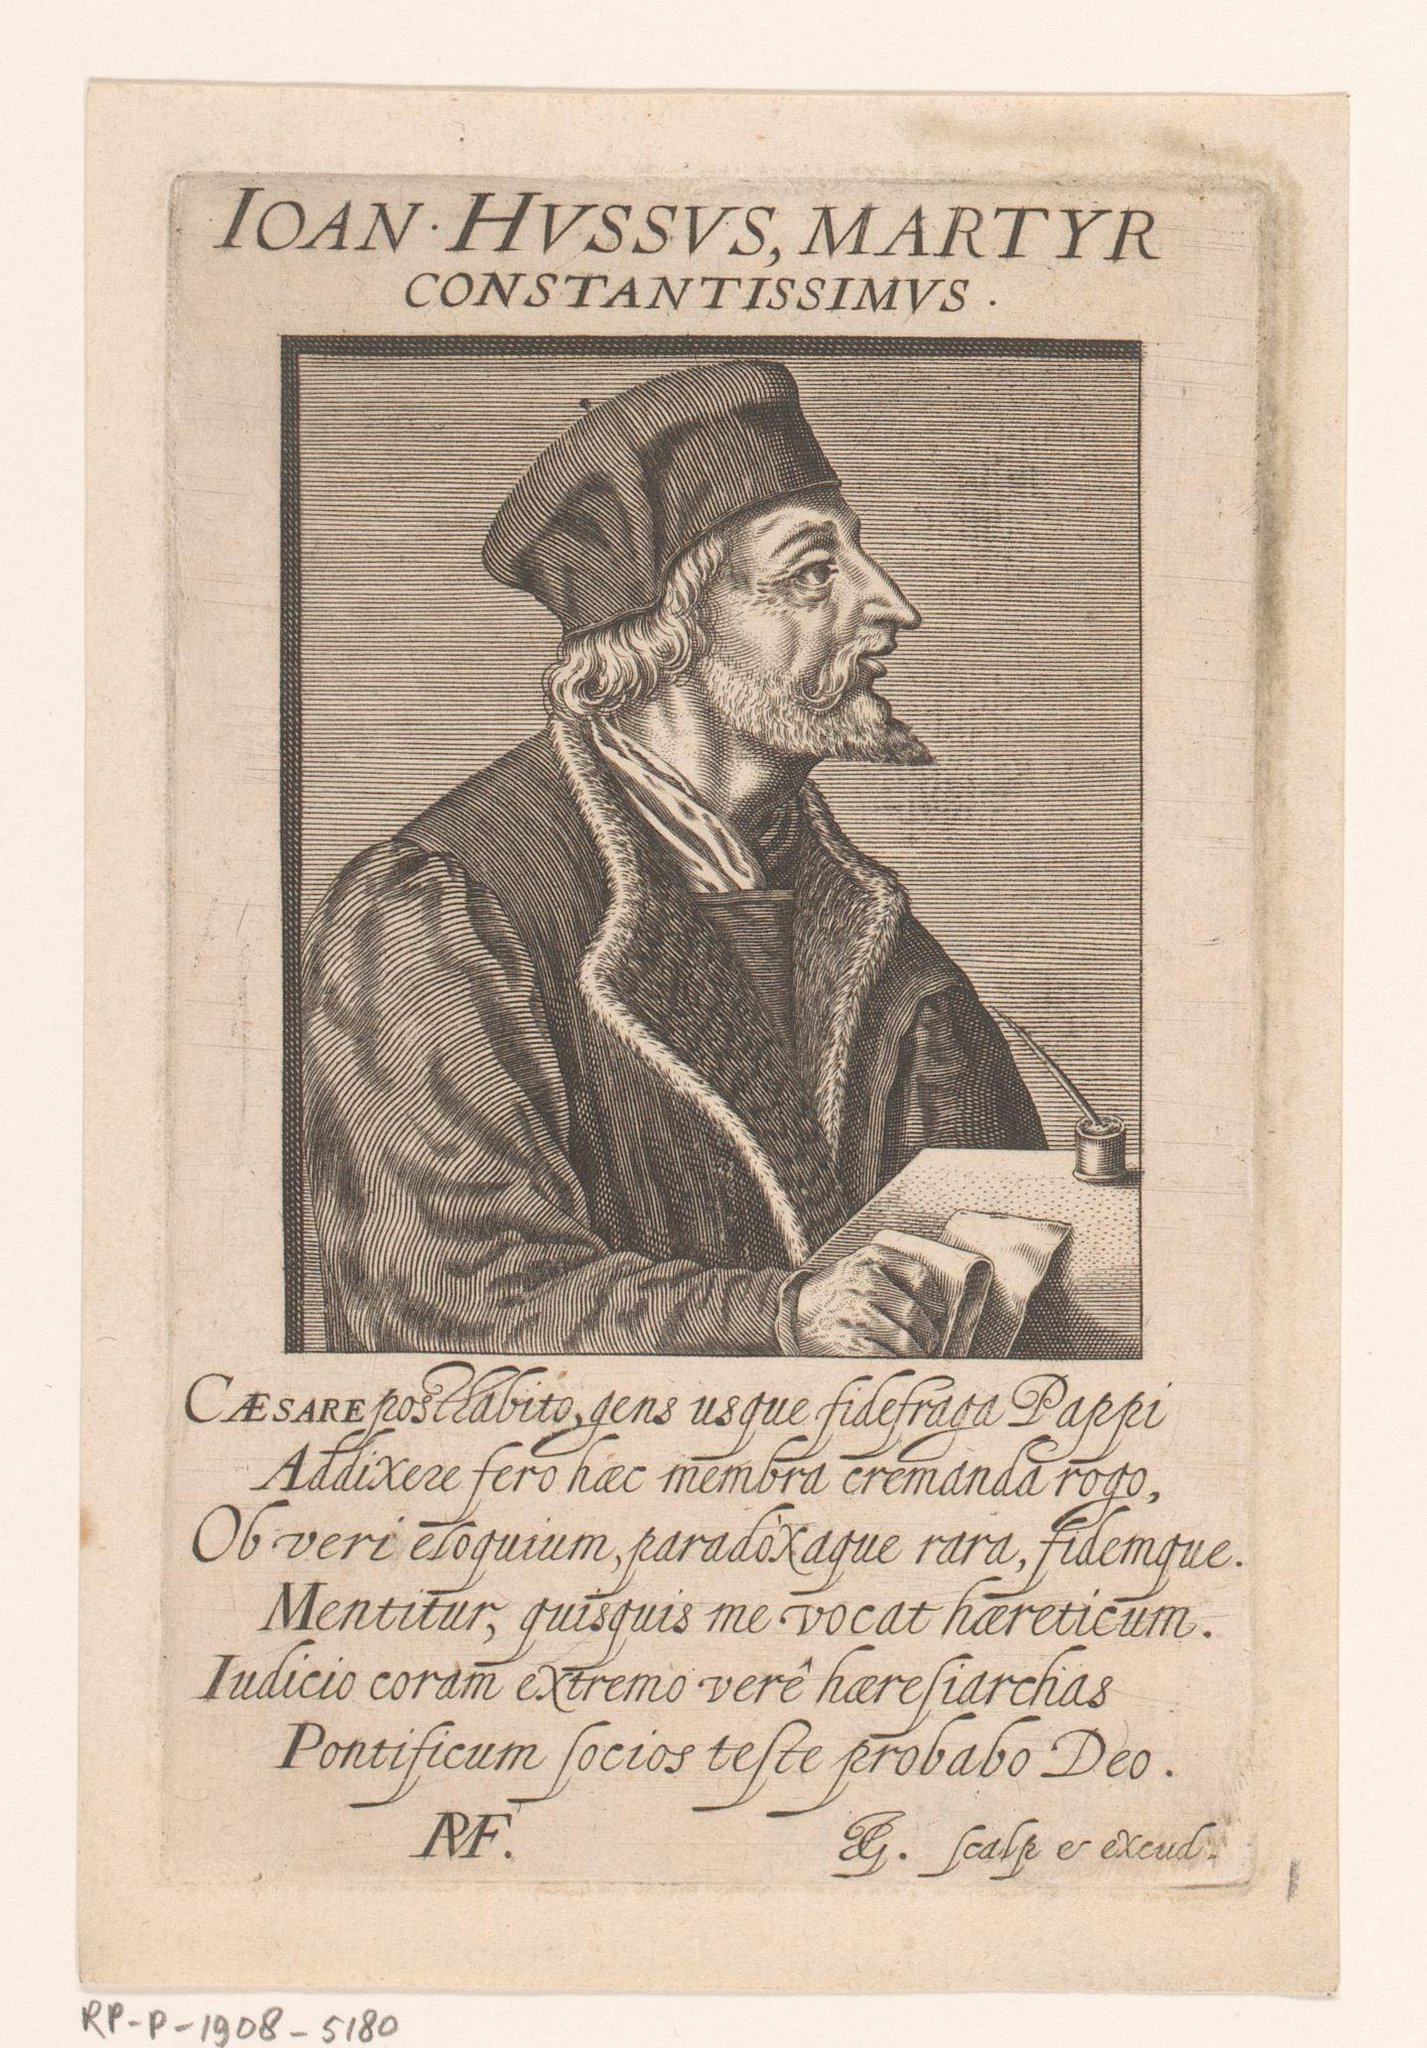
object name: print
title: Ioan Hussus, Martyr Constantissimus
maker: jacques granthomme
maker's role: print maker, publisher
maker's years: 1550-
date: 1588-1622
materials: paper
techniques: engraving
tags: historical persons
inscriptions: collector's mark: Lugt 2228